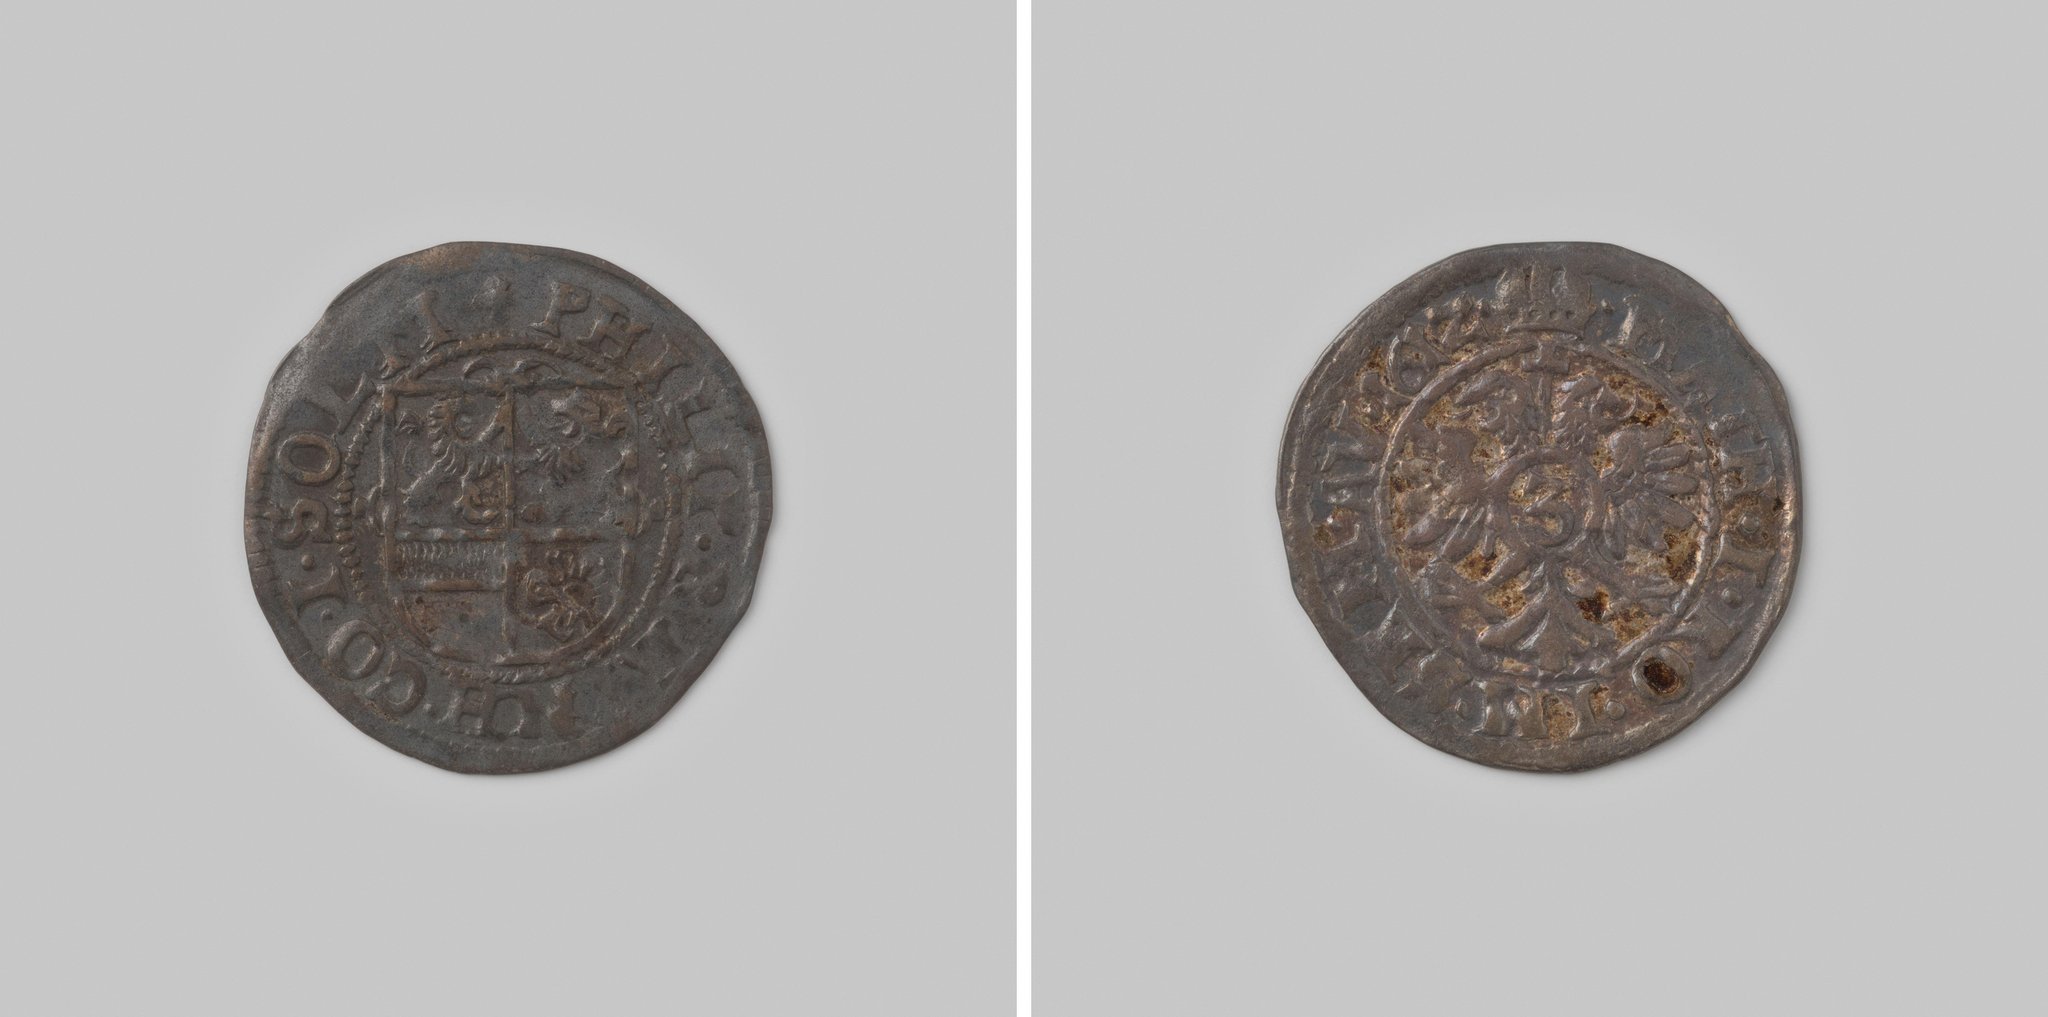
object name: coin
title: 3 kreuzer uit het vorstendom Solms-Hohensolms-Lich van Philipp Reinhard I, 1612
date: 1612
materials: silver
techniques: striking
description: Zilveren munt. Voorzijde: op versiering samengesteld wapenschild. Keerzijde: dubbelkoppige adelaar met op de borst rijksappel, waarin waarde-aanduiding: 3.